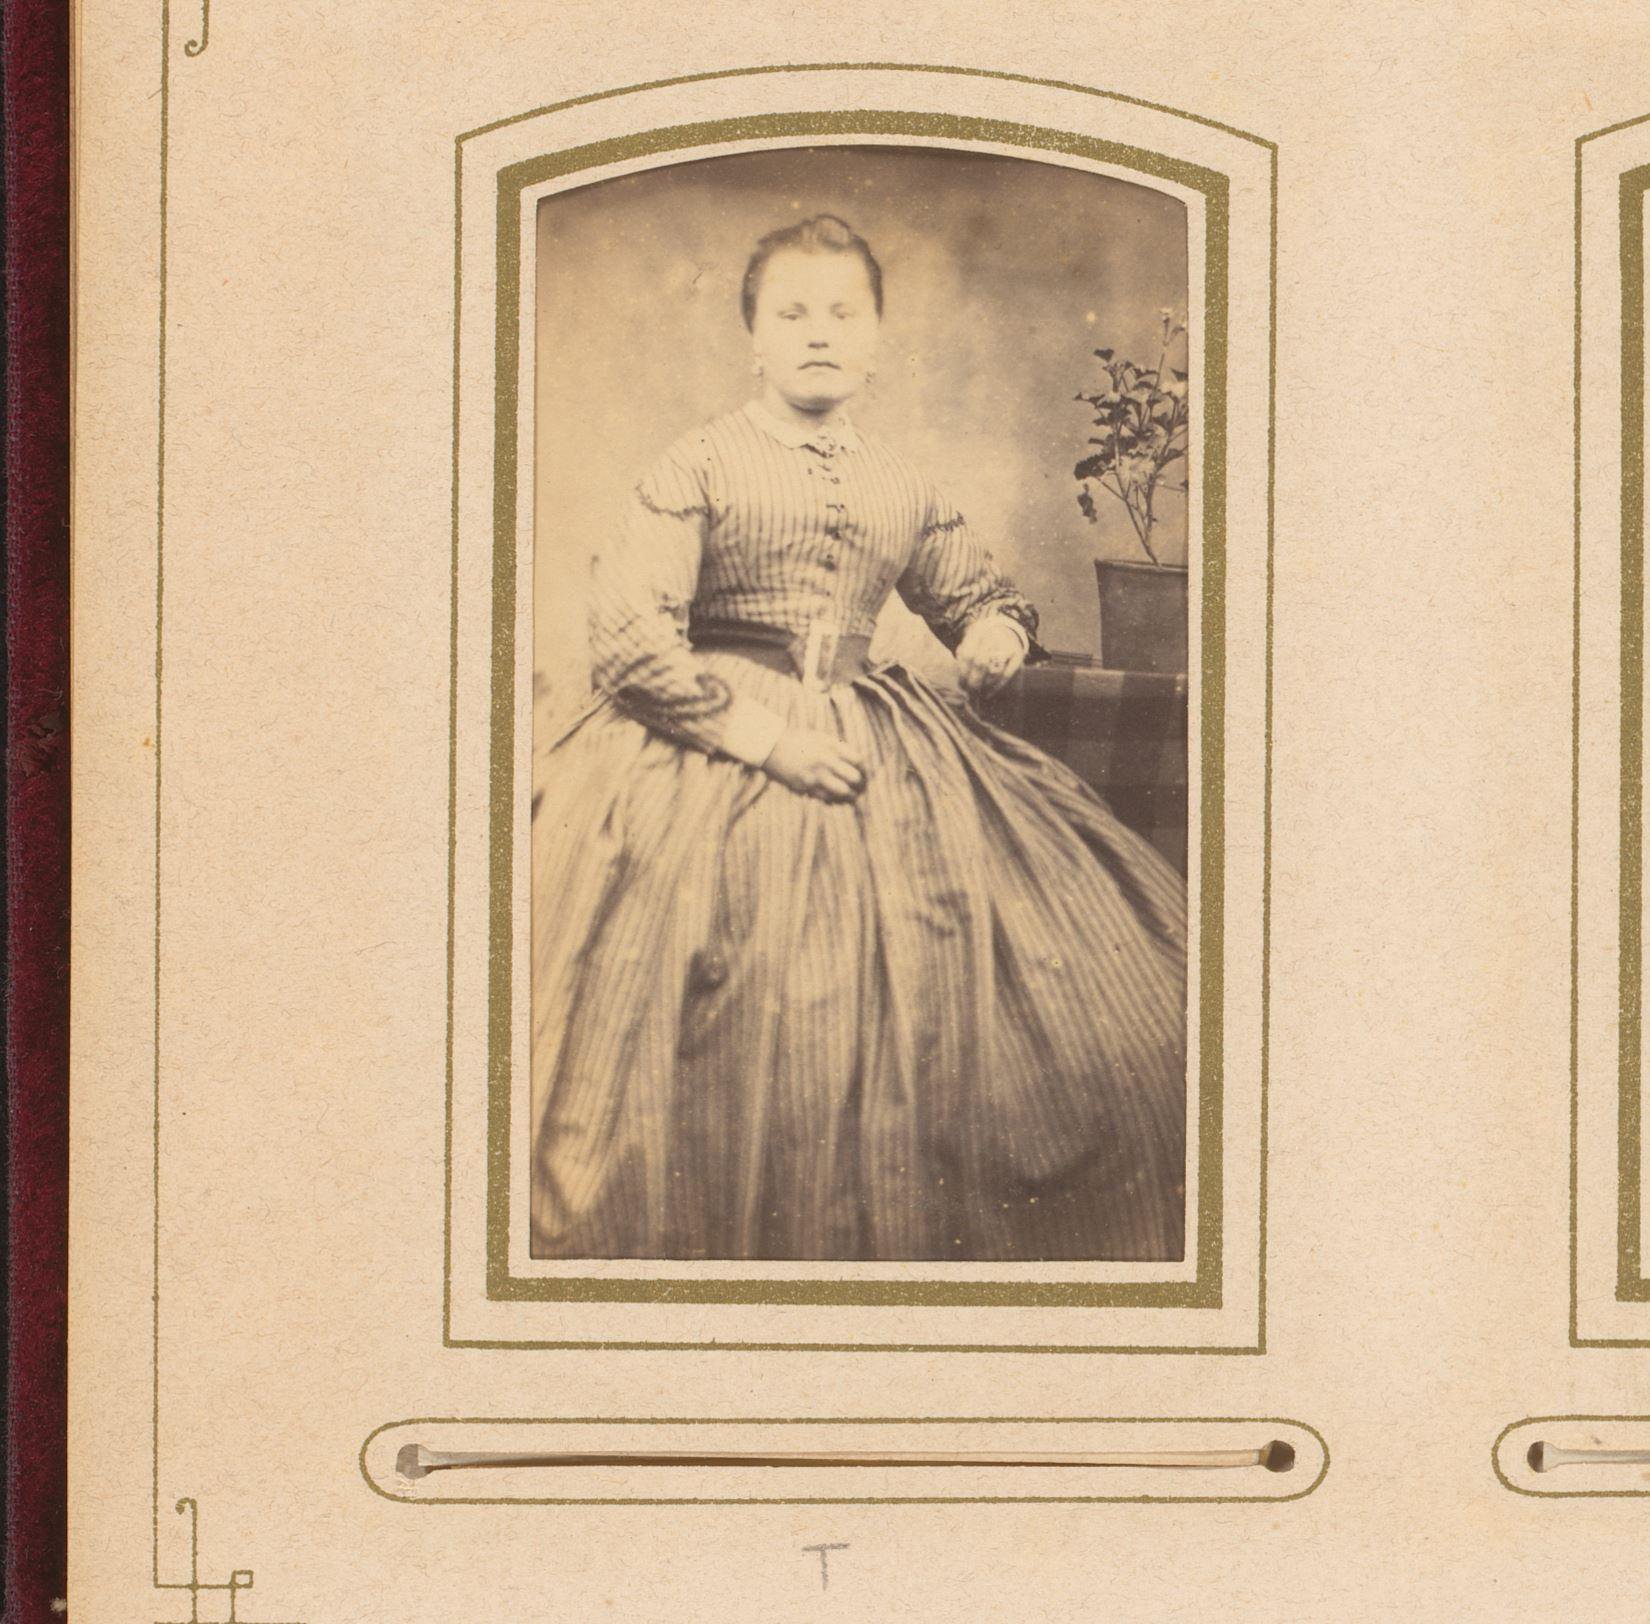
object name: photograph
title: Portret van een jonge vrouw, zittend aan een tafel met plant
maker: Anonymous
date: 1860-1900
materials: cardboard, photographic support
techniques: albumen print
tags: plants (in general), sitting figure - aa - female human figure, historical persons - bb - woman